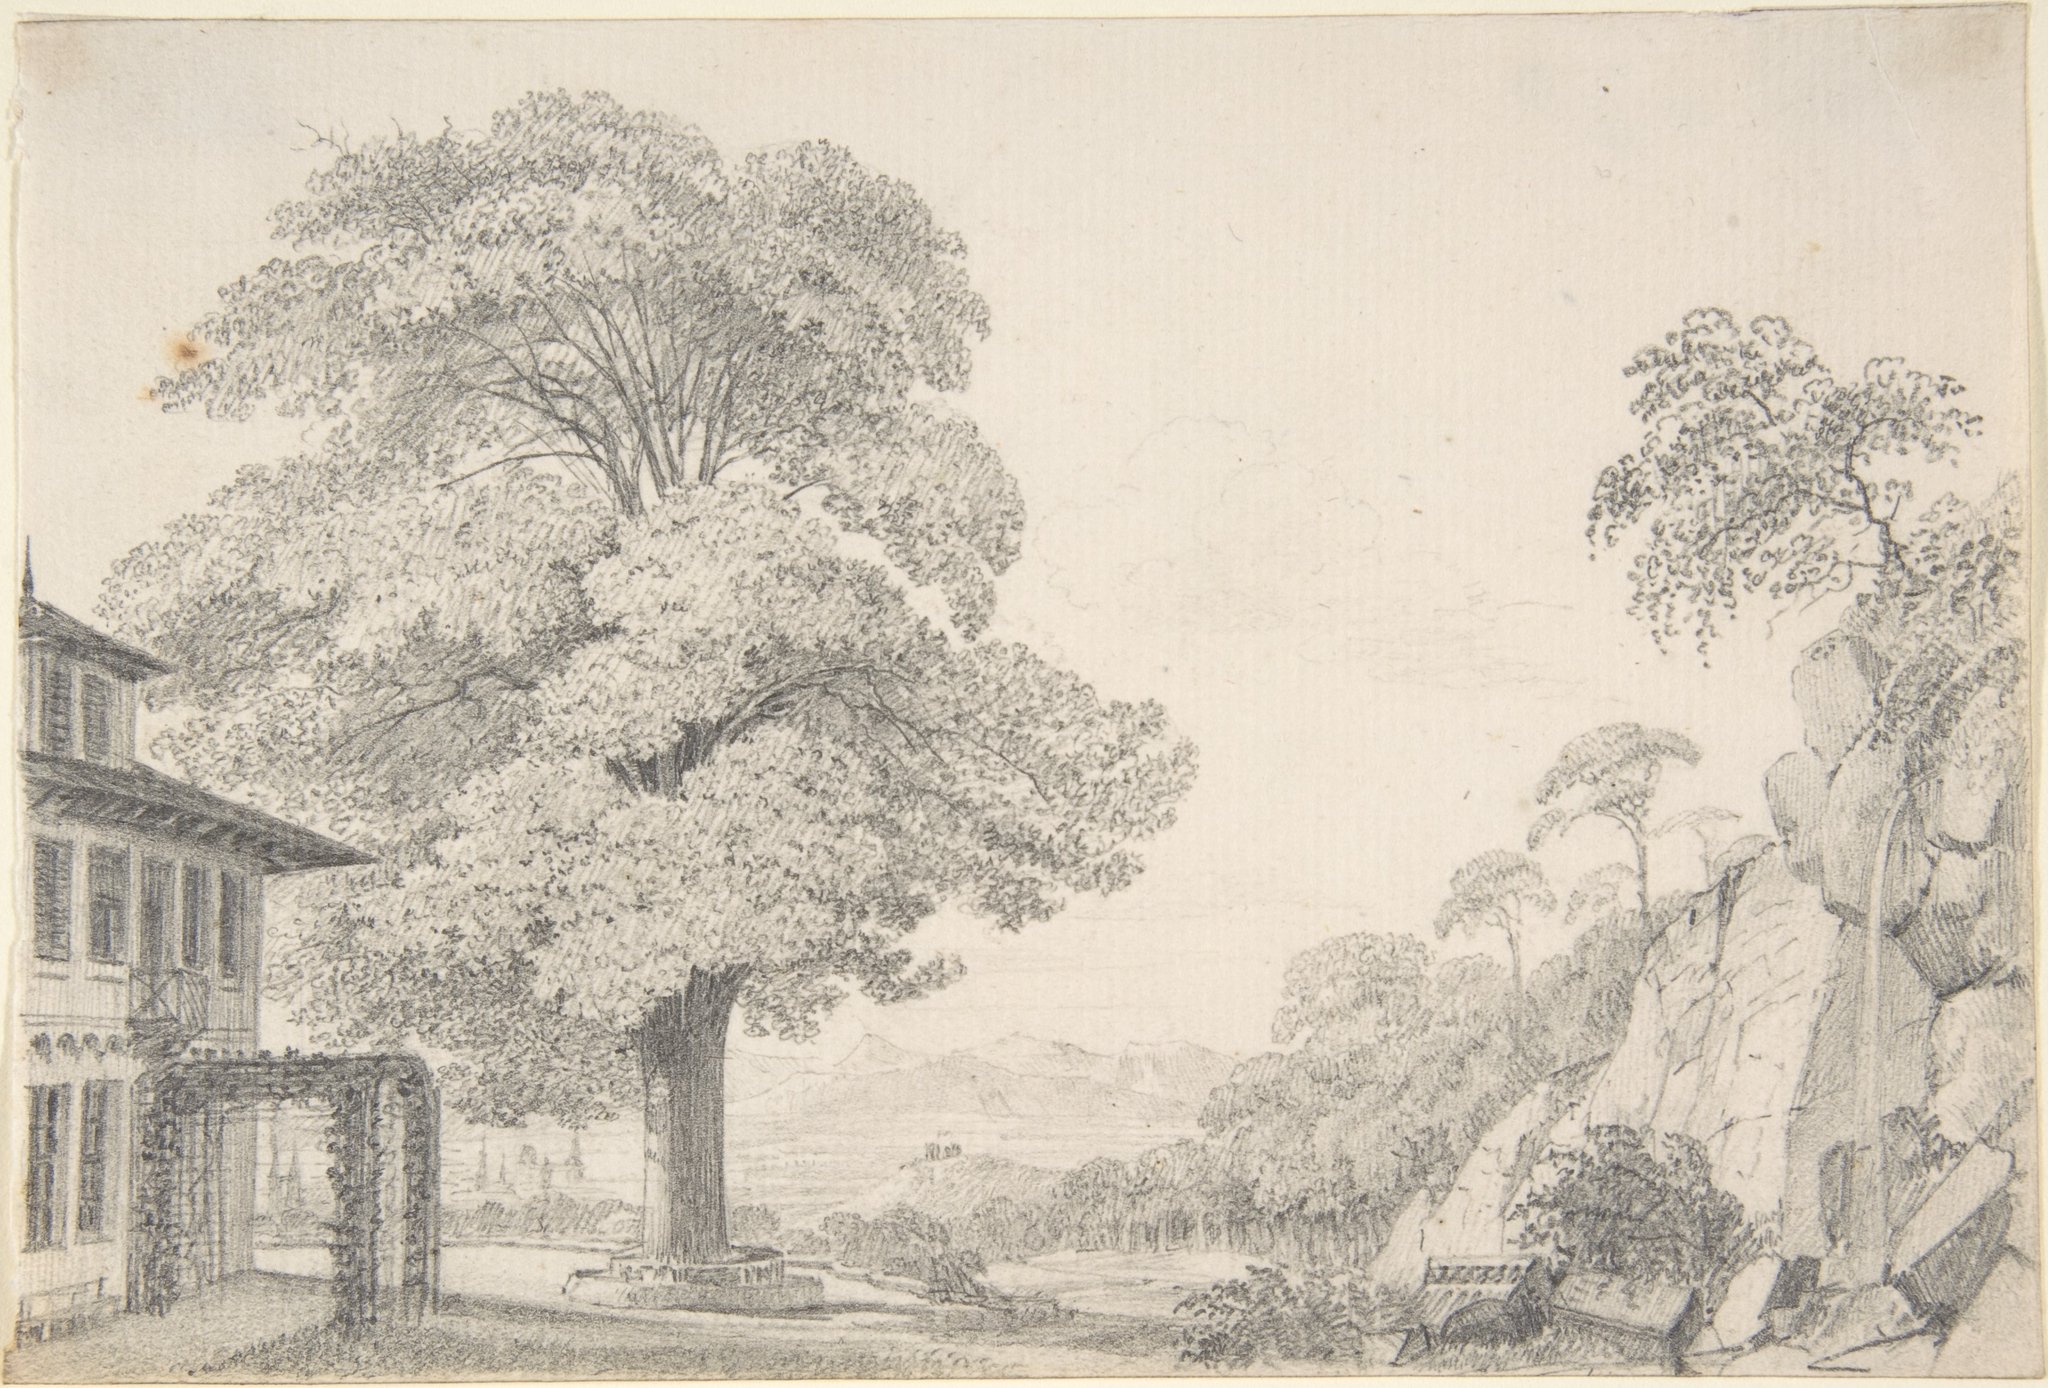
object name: drawing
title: Landscape with a Tree in front of a Villa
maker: eduard gaertner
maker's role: artist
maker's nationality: german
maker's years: 1801-1877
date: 1801-1877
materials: graphite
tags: houses,landscapes,trees